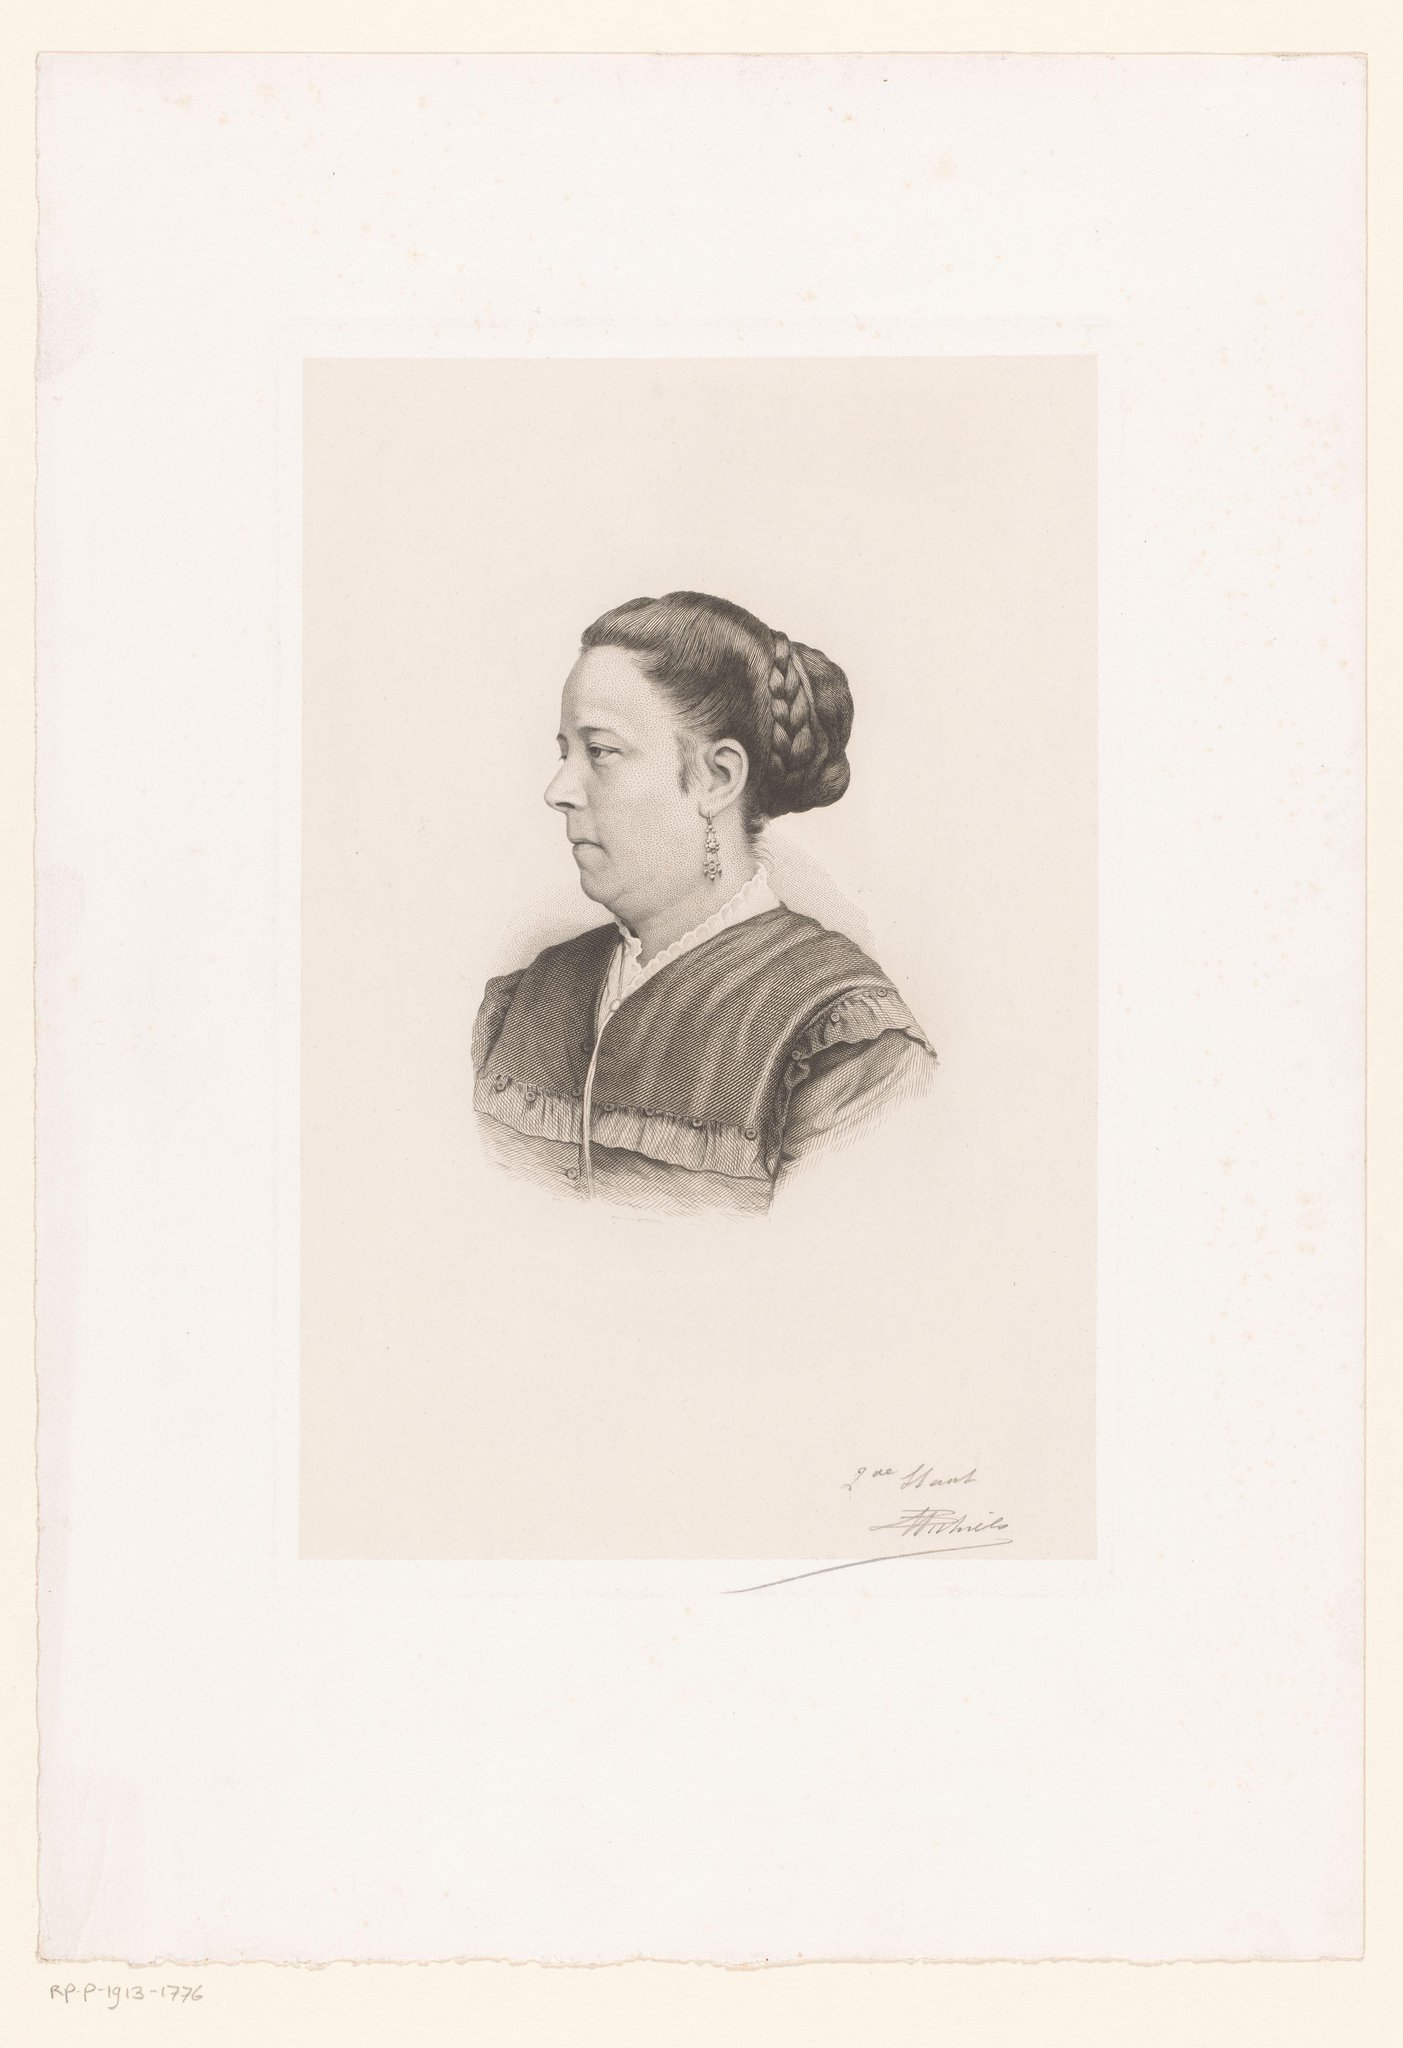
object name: print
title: Portret van een onbekende vrouw, mogelijk mevrouw Claes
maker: jean baptiste pierre michiels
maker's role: print maker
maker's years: 1821-1890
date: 1831-1890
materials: paper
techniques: etching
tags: adult woman, historical persons, ear-rings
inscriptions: inscription: ‘2me Staat’, collector's mark: Lugt 2228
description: In inventaris opgenomen onder de naam: 'Mme Claes'.